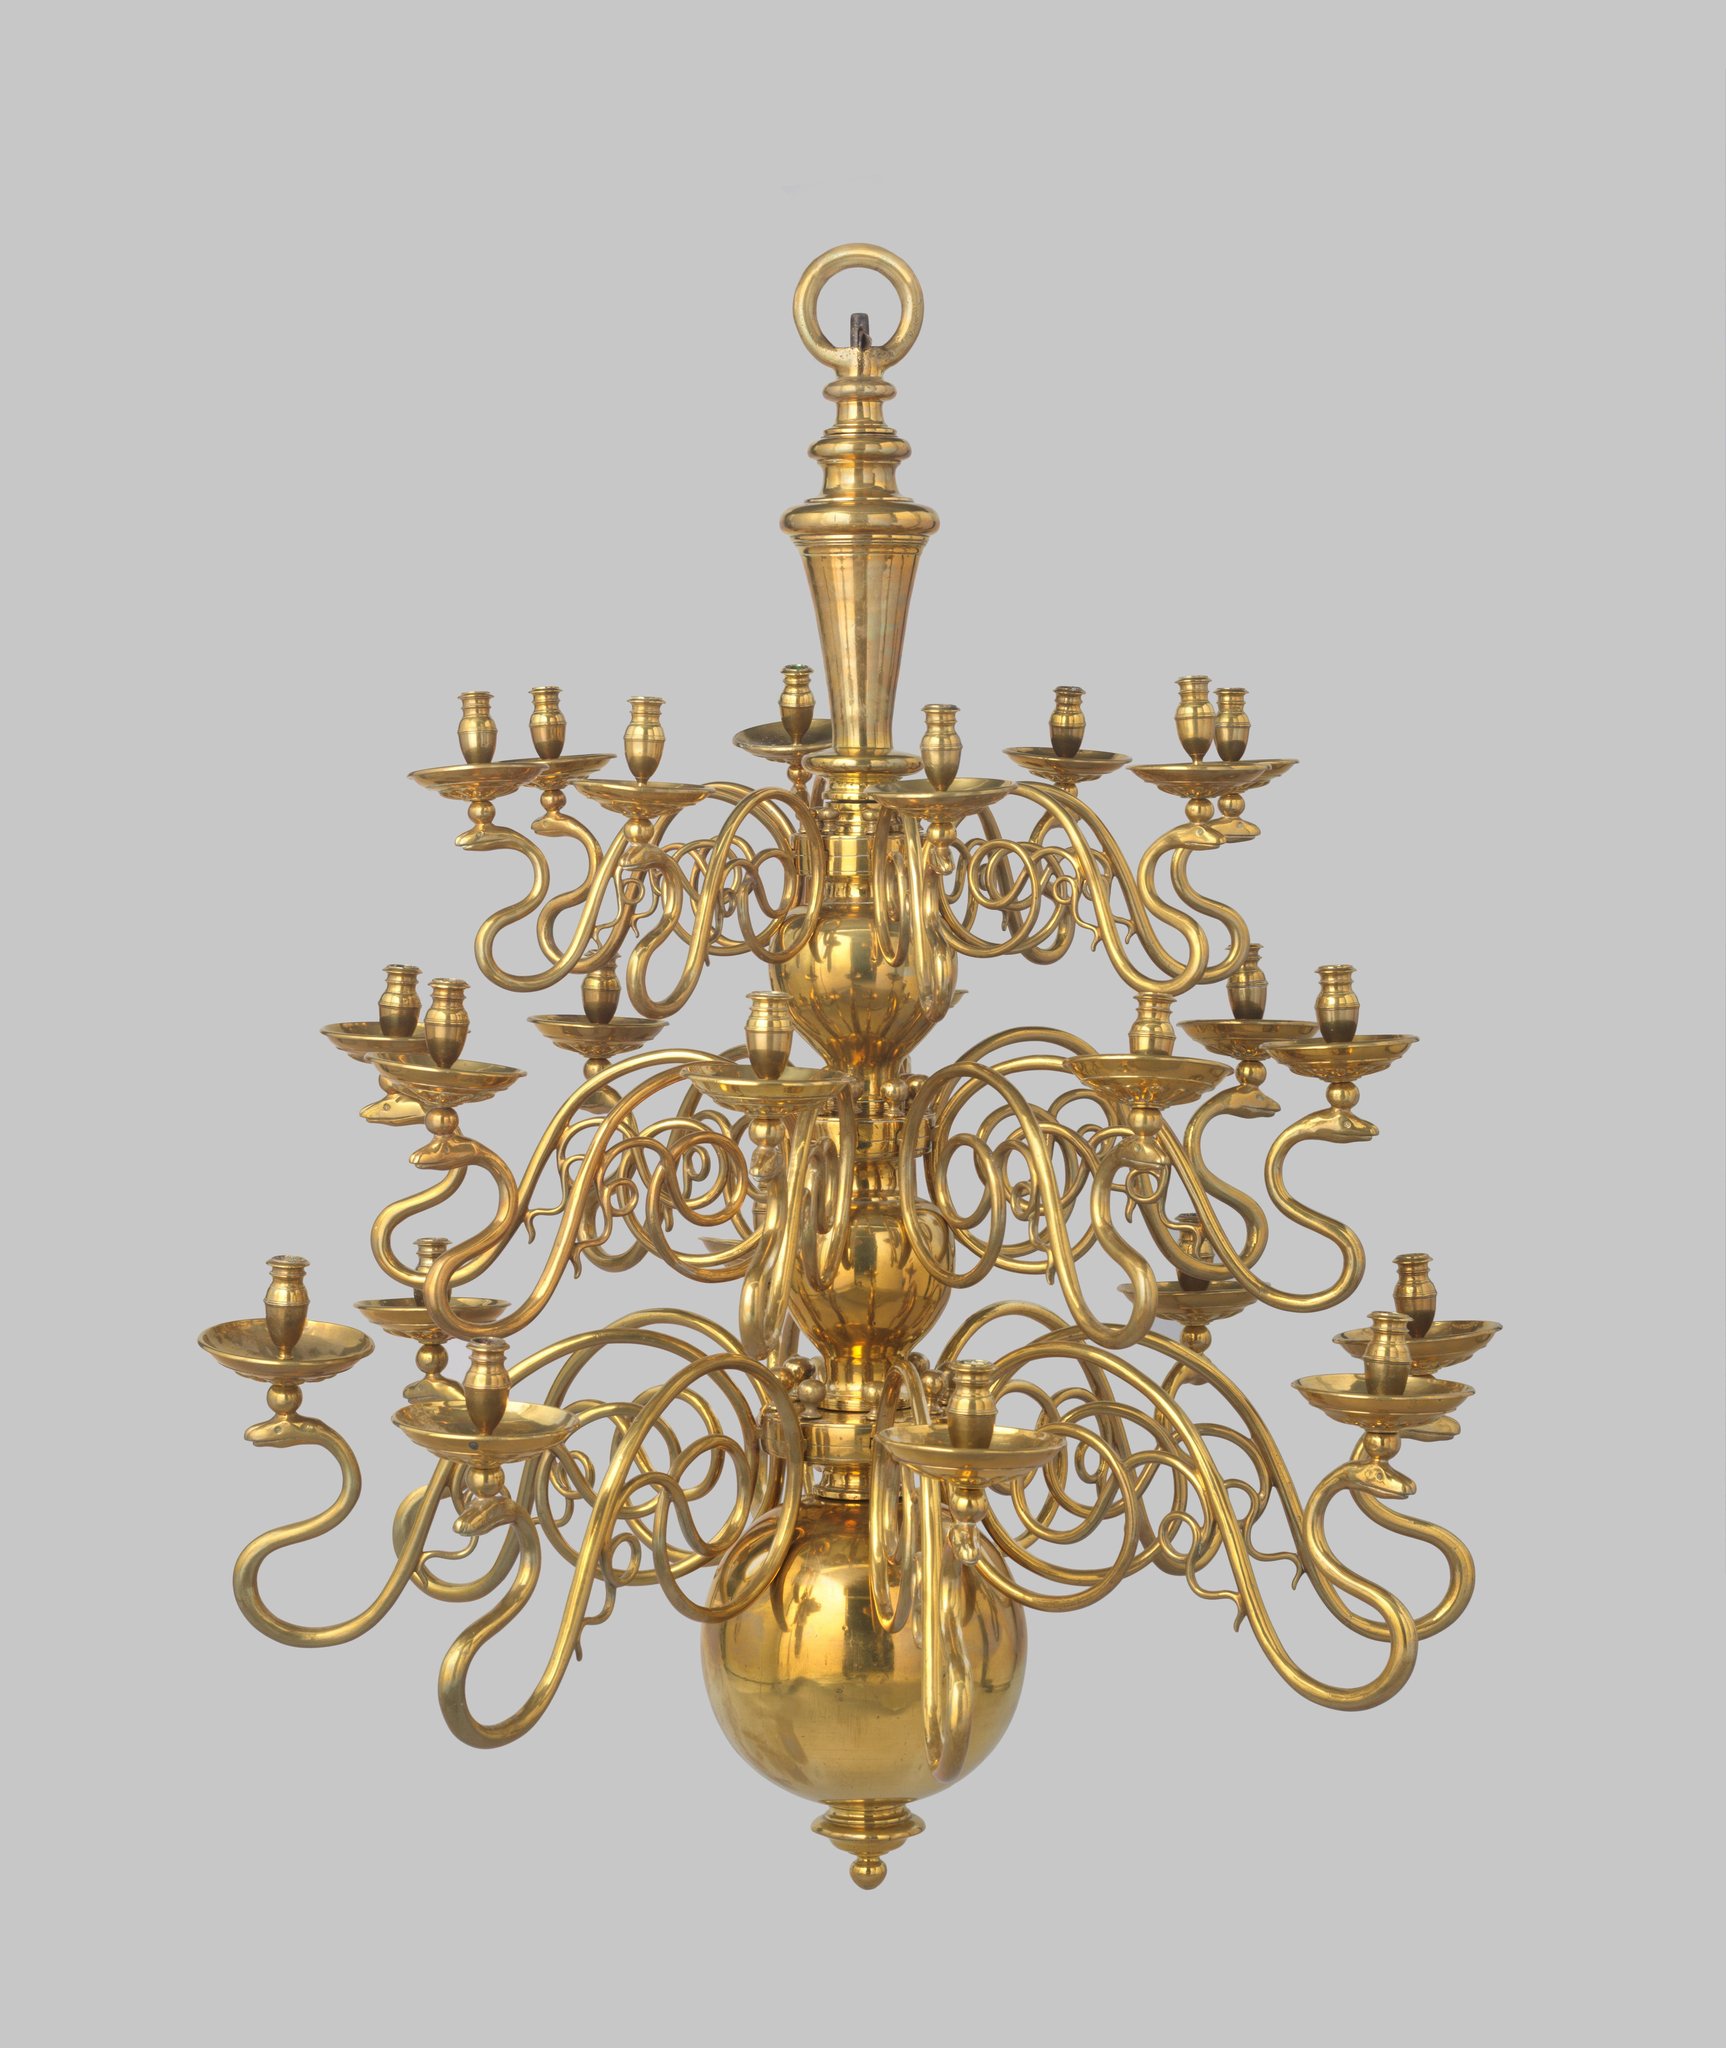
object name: chandelier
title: Arm van een kaarsenkroon in drie hoogten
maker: Anonymous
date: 1625-1650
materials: brass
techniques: casting, screwed, turning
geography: northern netherlands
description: De arm is aan de stamzijde voorzien van een nok, waarin een gat is aangebracht om ze met een pin in de standringen te kunnen vastzetten. De S-vormige arm heeft de gedaante van een slang met een naar de stamzijde gekronkelde staart en naar buiten toe een opgeheven kop met daarop een ronde knop, waarin het van een schroefdraad voorziene gat is aangebracht ter bevestiging van de kaarsenhouders met de vetvangers. De arm is met behulp van hetzelfde model gegoten als de overige armen van de krans. De ronde kaarsenhouder is vaasvormig met een geprofileerde rib. Bovenaan heeft zij twee holronde profileringen, en een uitkragende rand en onderaan een uit twee holronde profileringen bestaande voet. De voet loopt uit in een zich verjongend schroefeind met een centergat. De bolle vetvanger is aan de bovenkant glad en heeft aan de onderkant visblaasachtige godrons en een rib. De vetvanger is met behulp van hetzelfde model gegoten als de overige vetvangers van de krans. De pinnen zijn met bolle knoppen versierd. Dit is de derde arm van de bovenste standring, genummerd op de nok met het cijfer III.